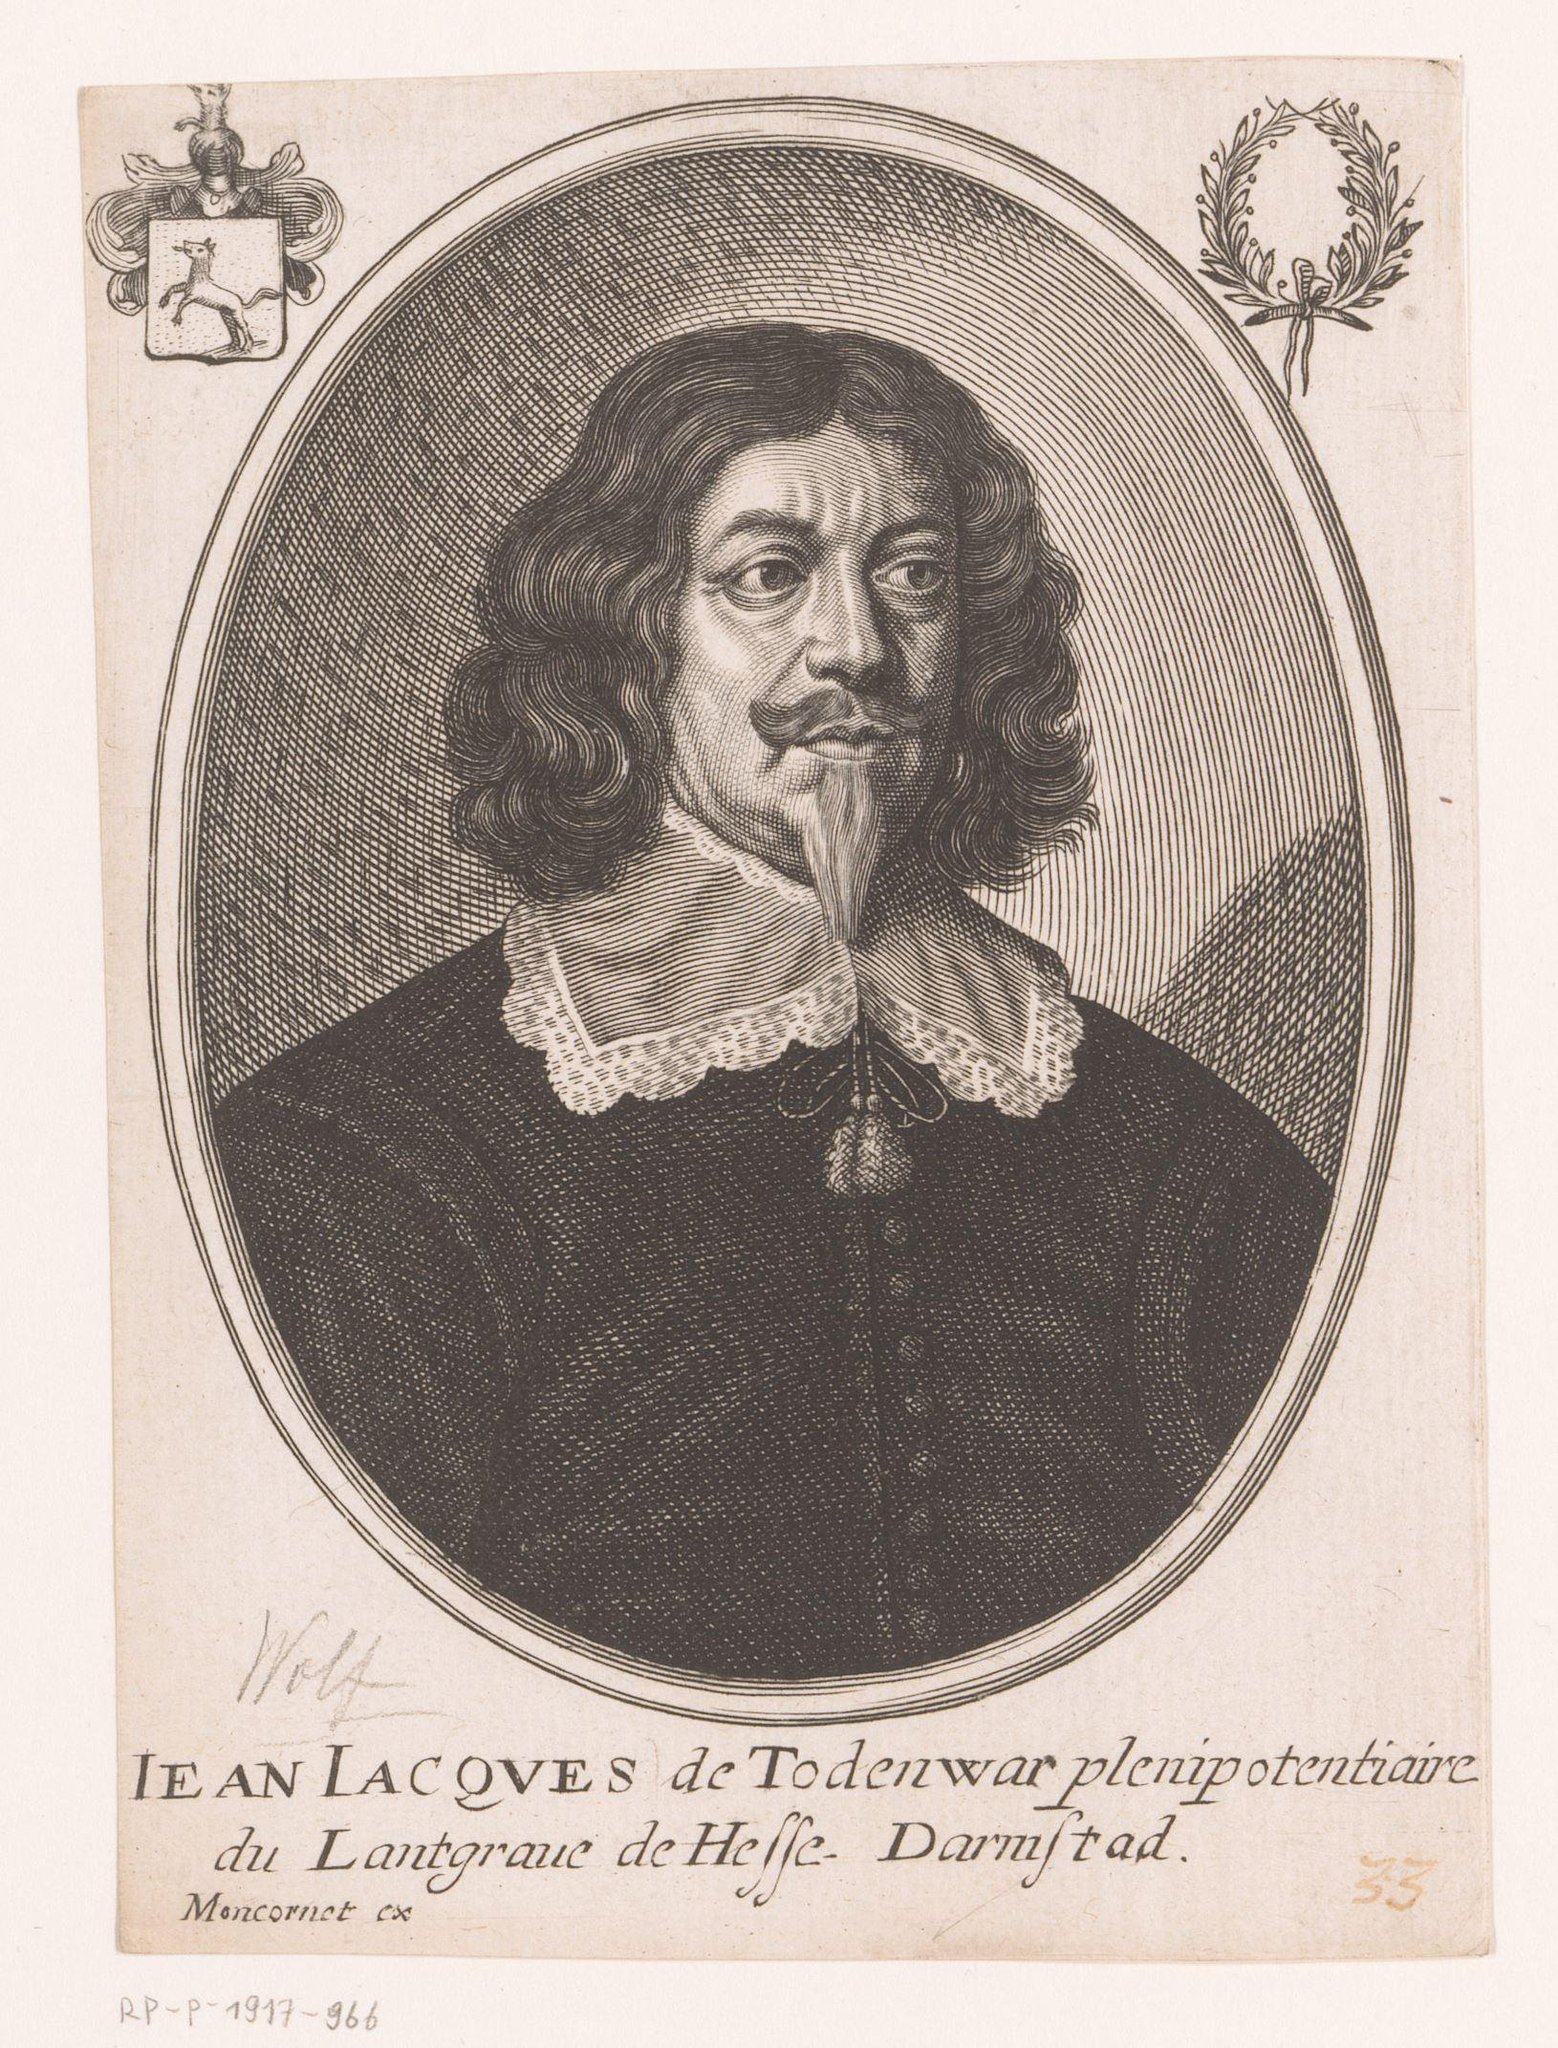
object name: print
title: Portret van Johann Jacob Wolf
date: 1625-1668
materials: paper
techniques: engraving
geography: paris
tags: historical persons, lawyer, attorney at law, diplomacy, diplomat, armorial bearing, heraldry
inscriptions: collector's mark: Lugt 2228